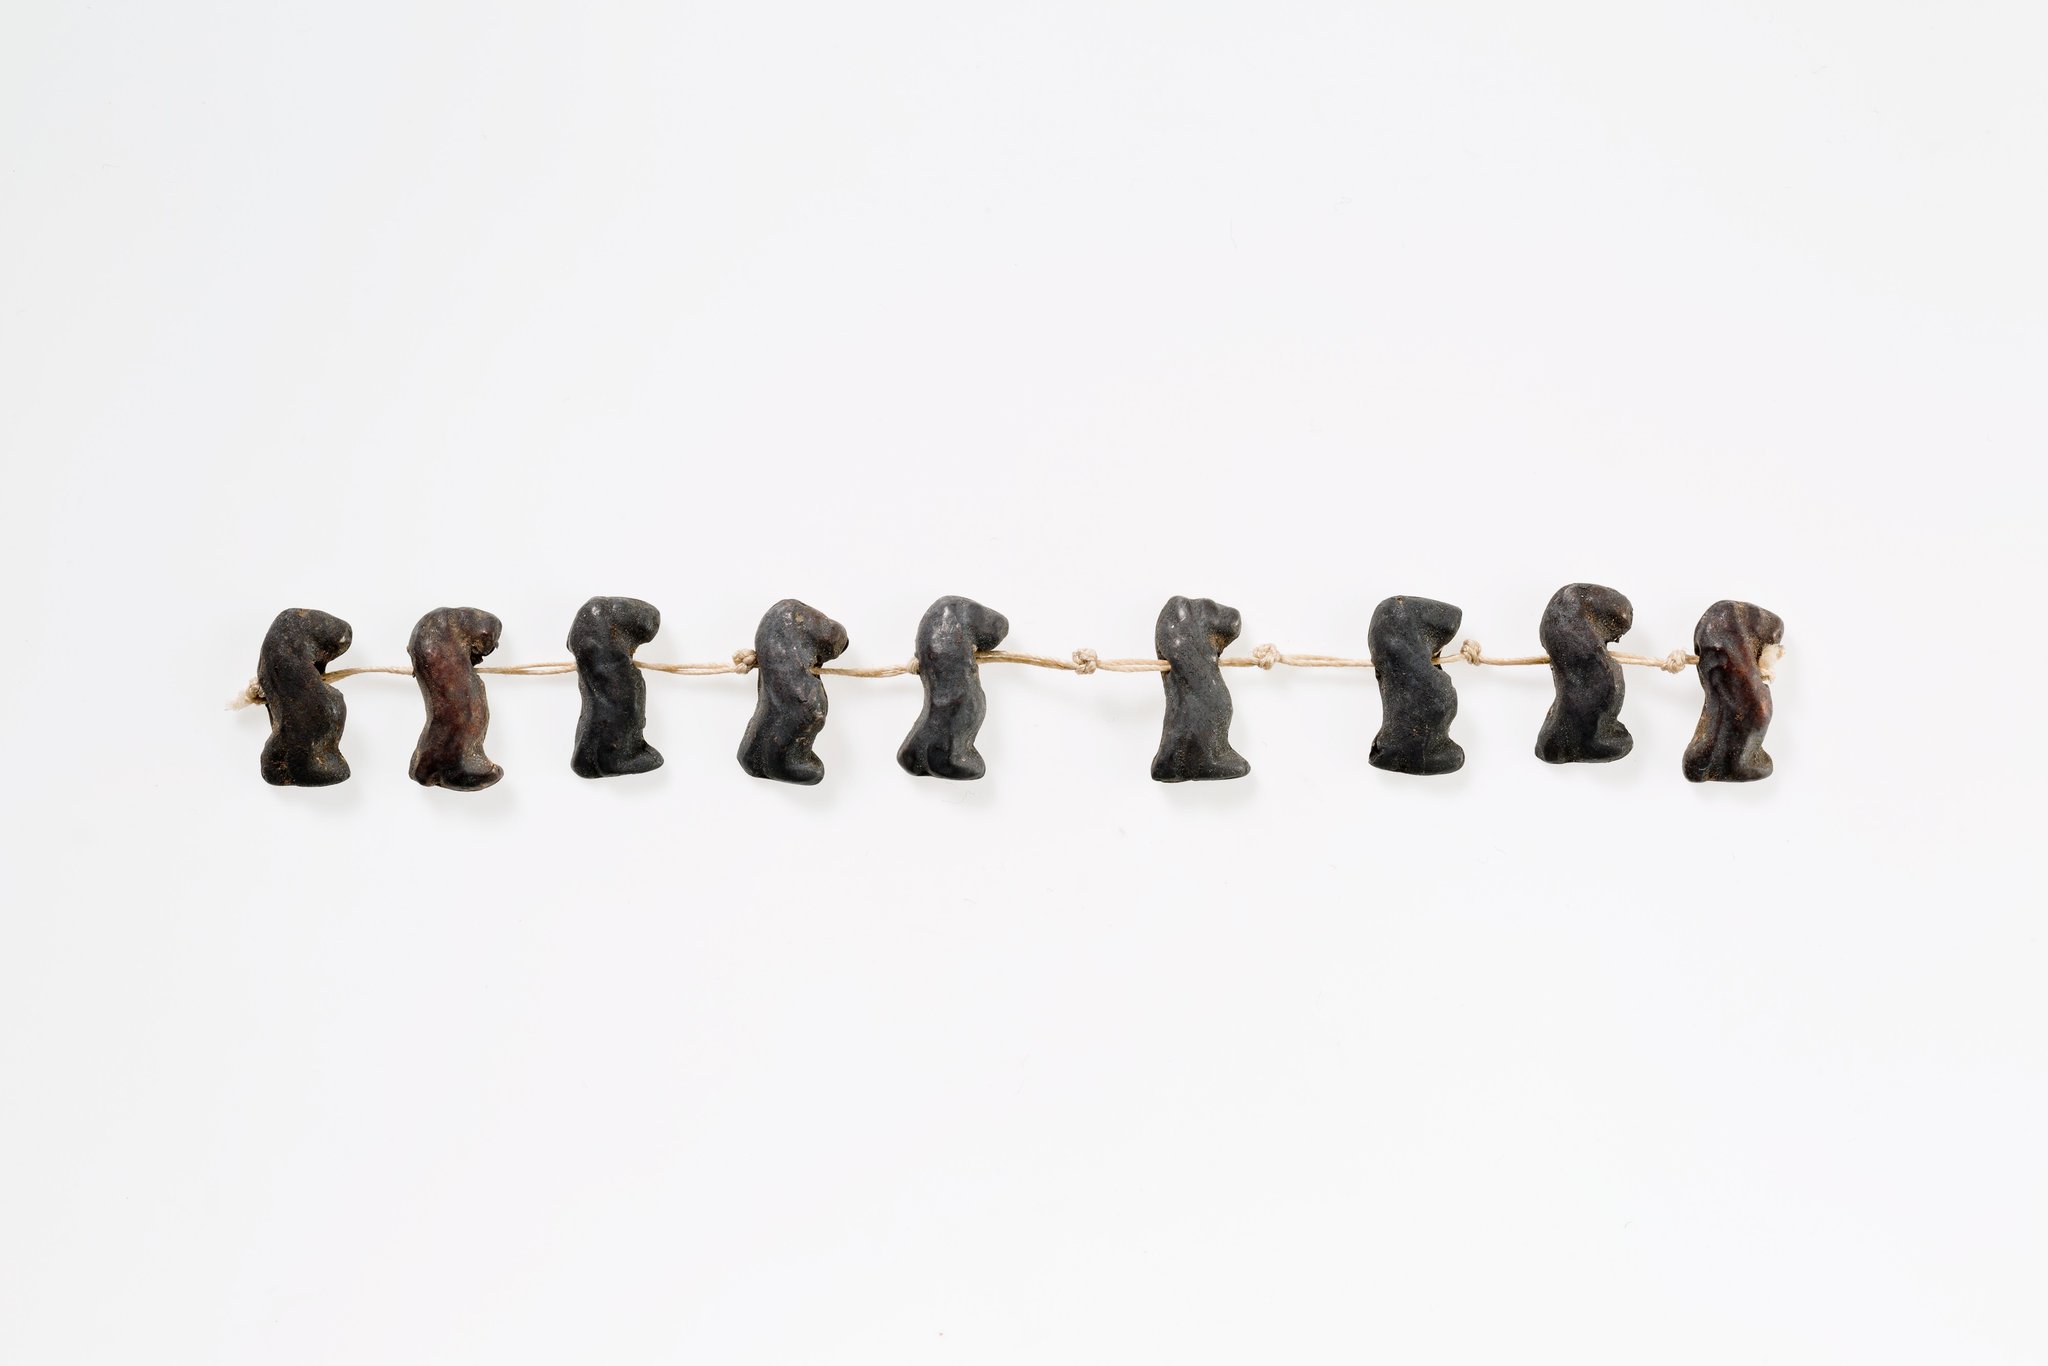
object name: amulet, taweret, strung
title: Nine Taweret Amulets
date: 1850-1700 BCE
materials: plaster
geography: egypt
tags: taweret